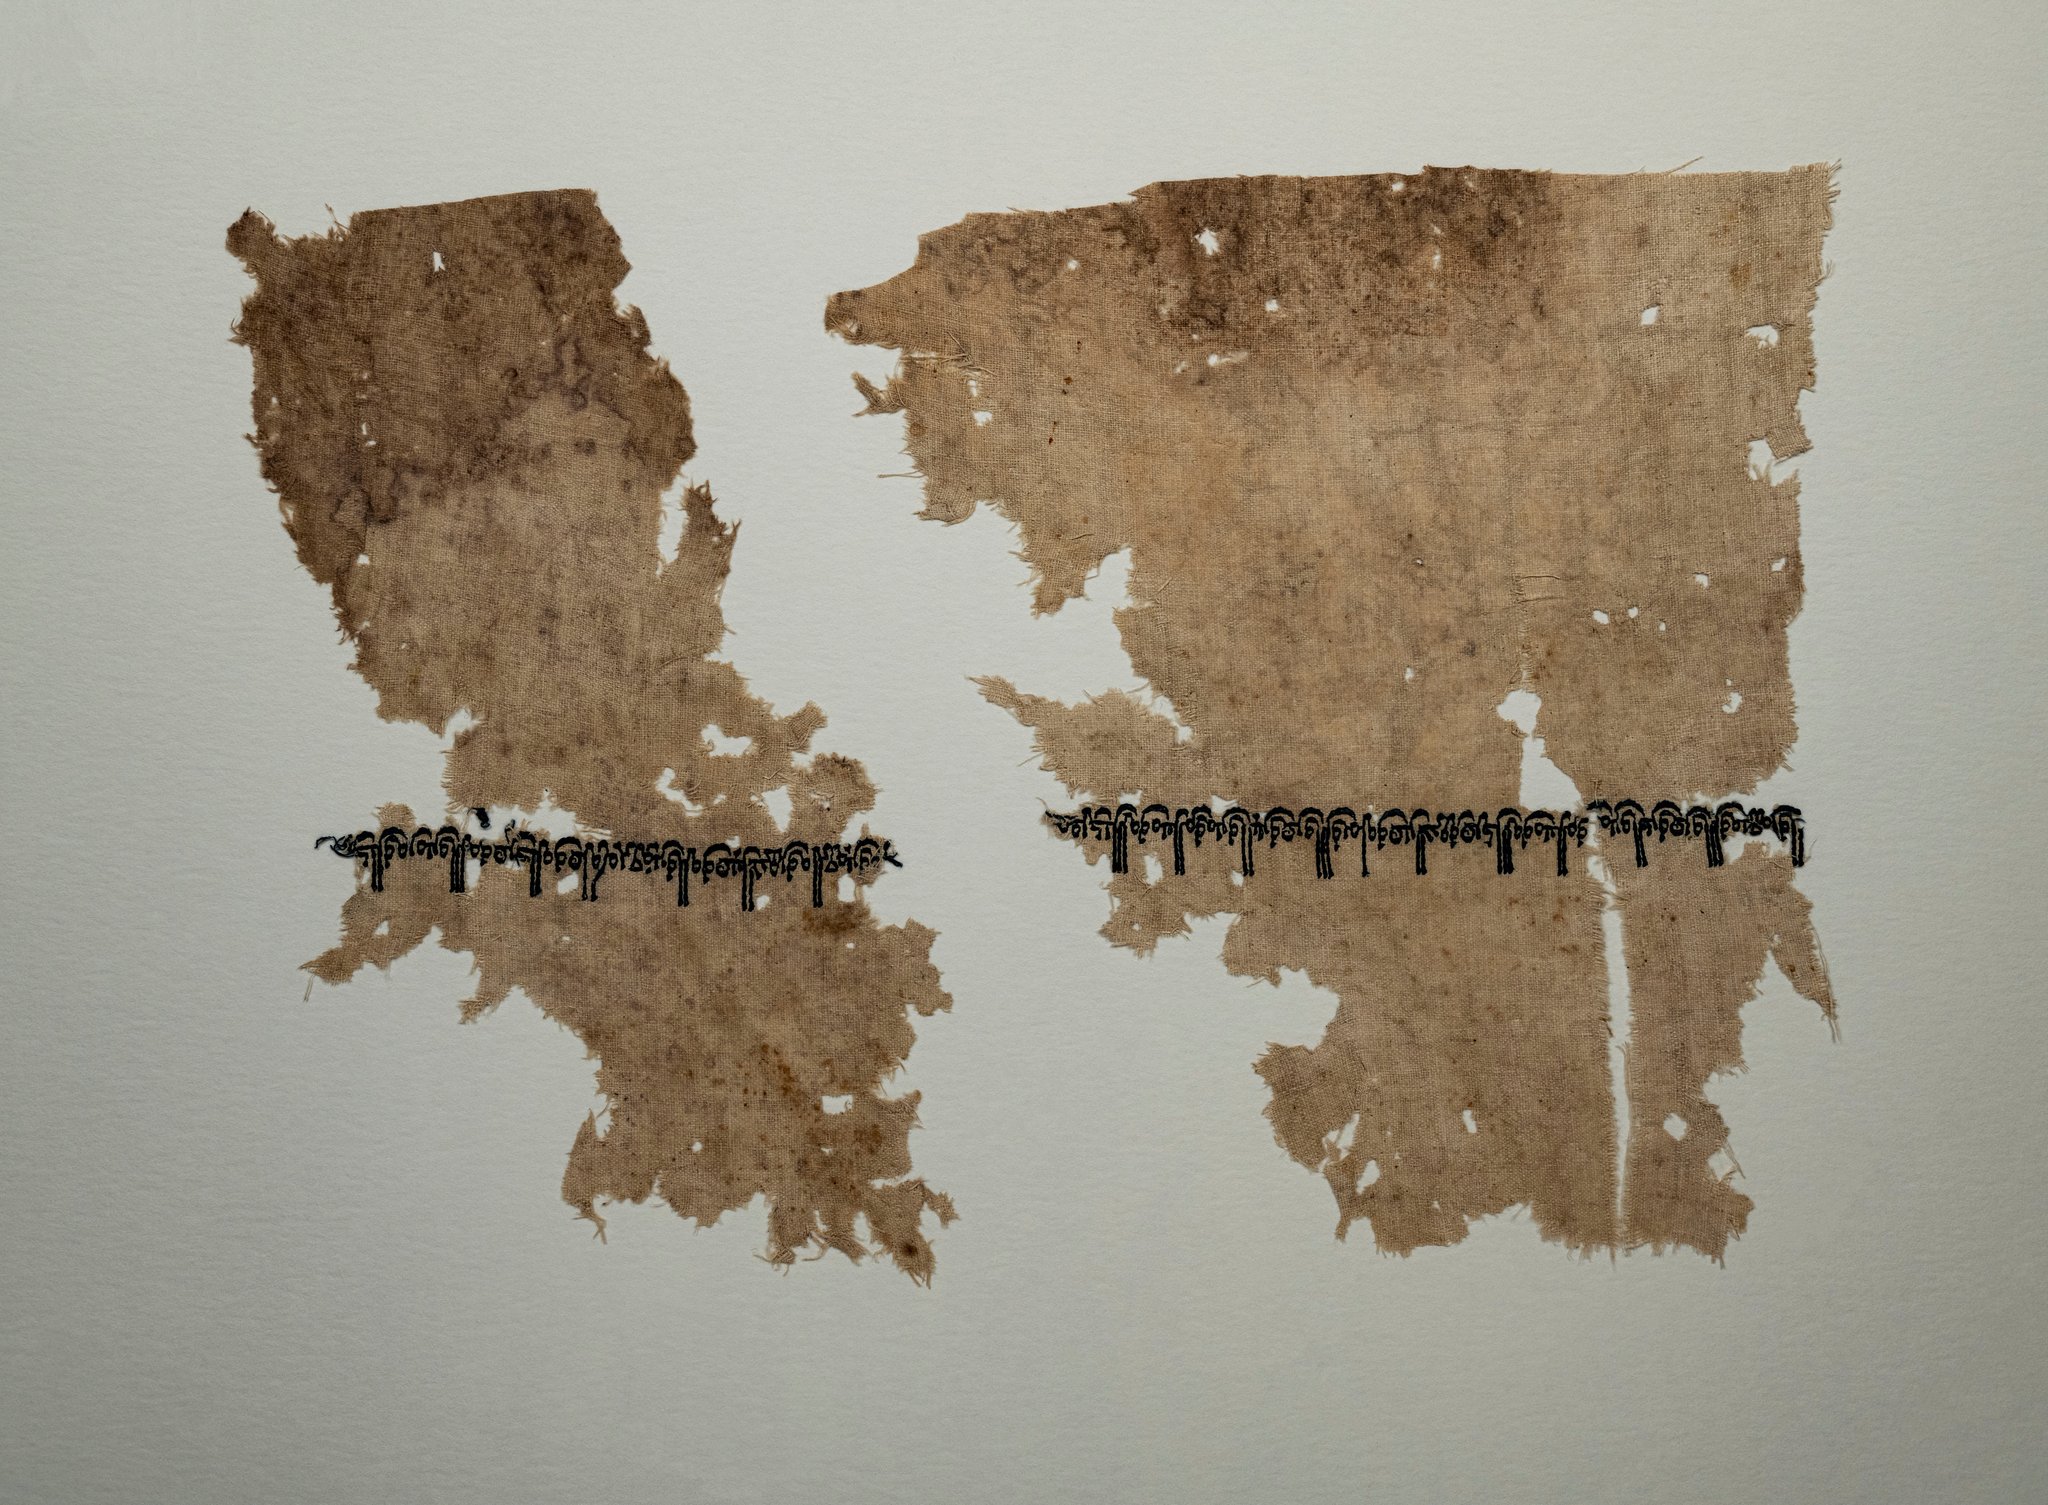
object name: textile fragment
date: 901-1000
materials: linen, silk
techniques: embroidery, weave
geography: egypt